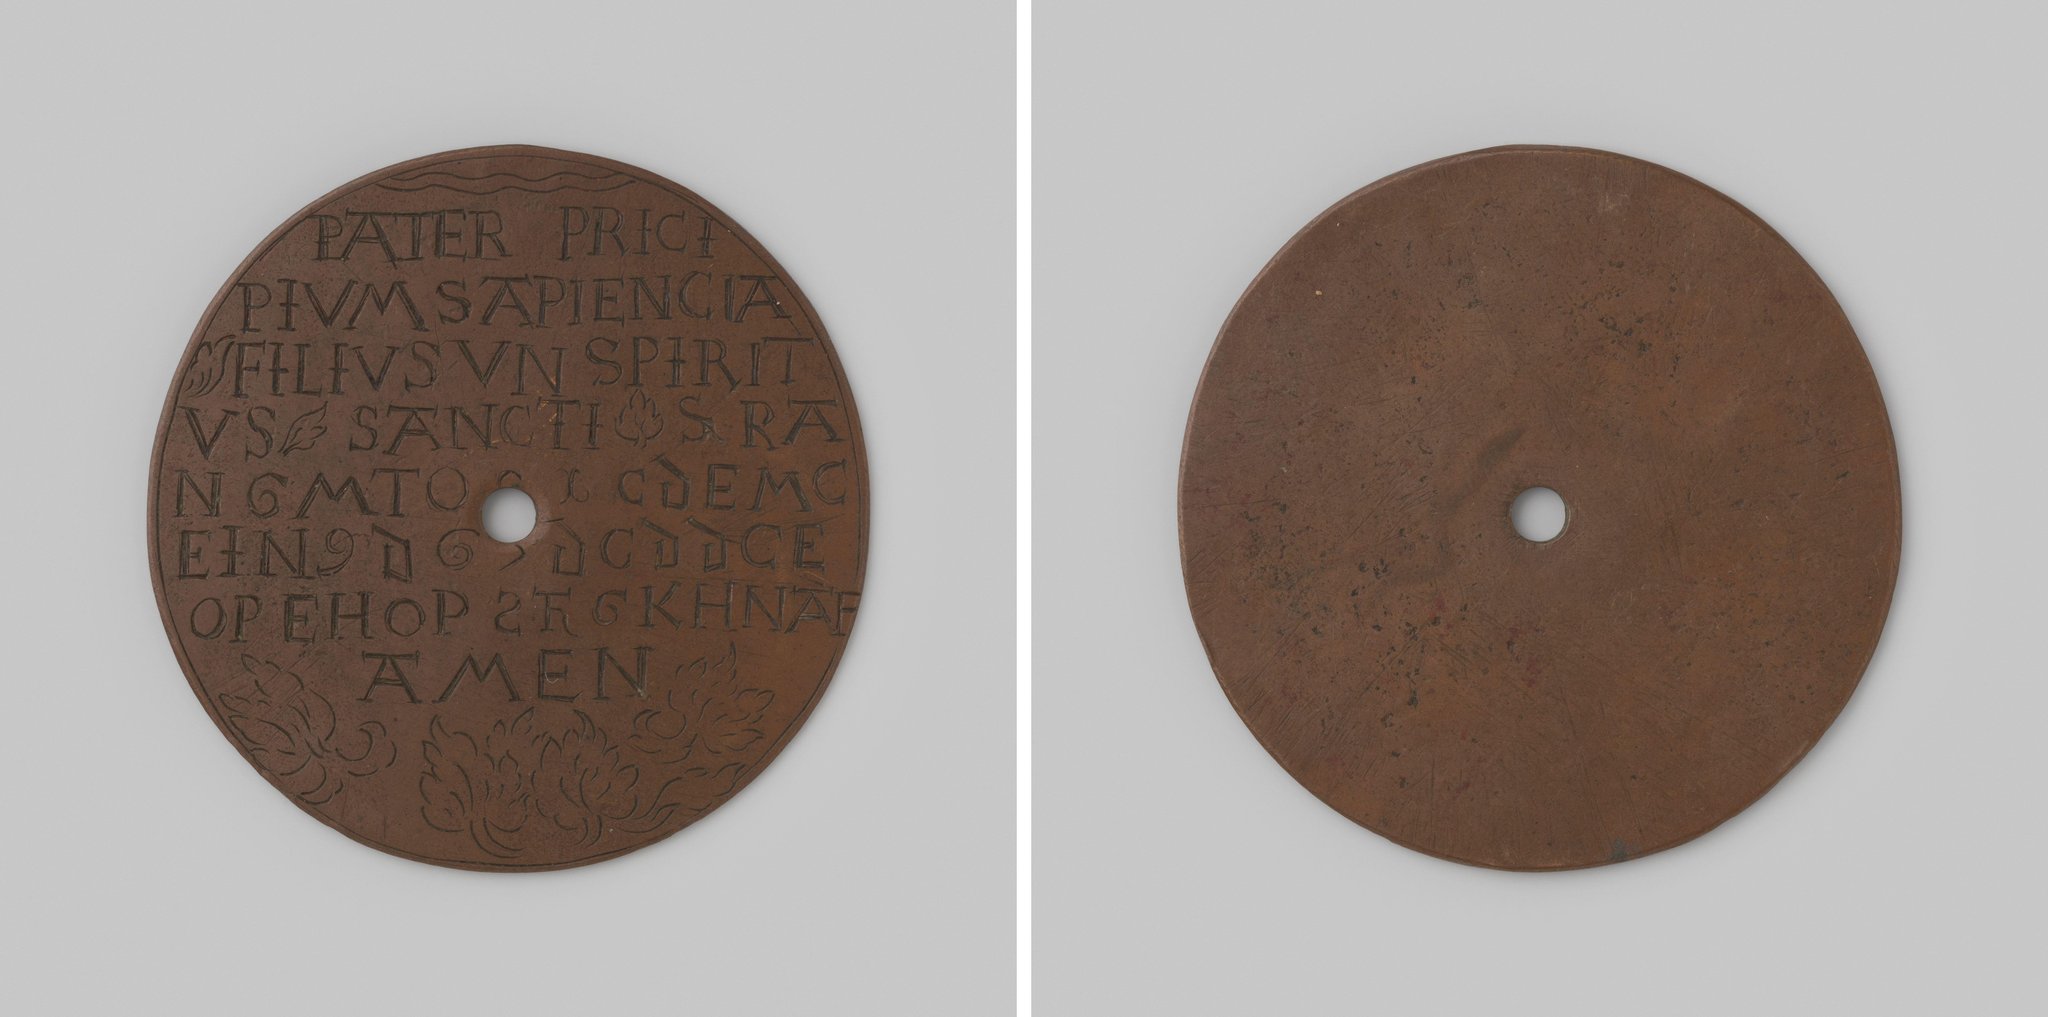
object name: history medal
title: Plaatje met opschrift, uit een bom van de troepen van de Bisschop van Munster, binnen Groningen geworpen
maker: Anonymous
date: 1672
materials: copper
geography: groningen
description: Koperen penning. Opschrift: PATER PRI(N)CI/ PIVM SAPIENCIA(E)/ FILIVS VN SPIRIT/ VS SANCTI [sanctus?] S. RA/ NEMTO, IC DEMC/ EINS DE DCDDCE/ OPE HOP STEKHN AB/ AMEN (De Vader, beginsel der wijsheid, de eniggeboren Zoon, de Heilige Geest ... Amen).